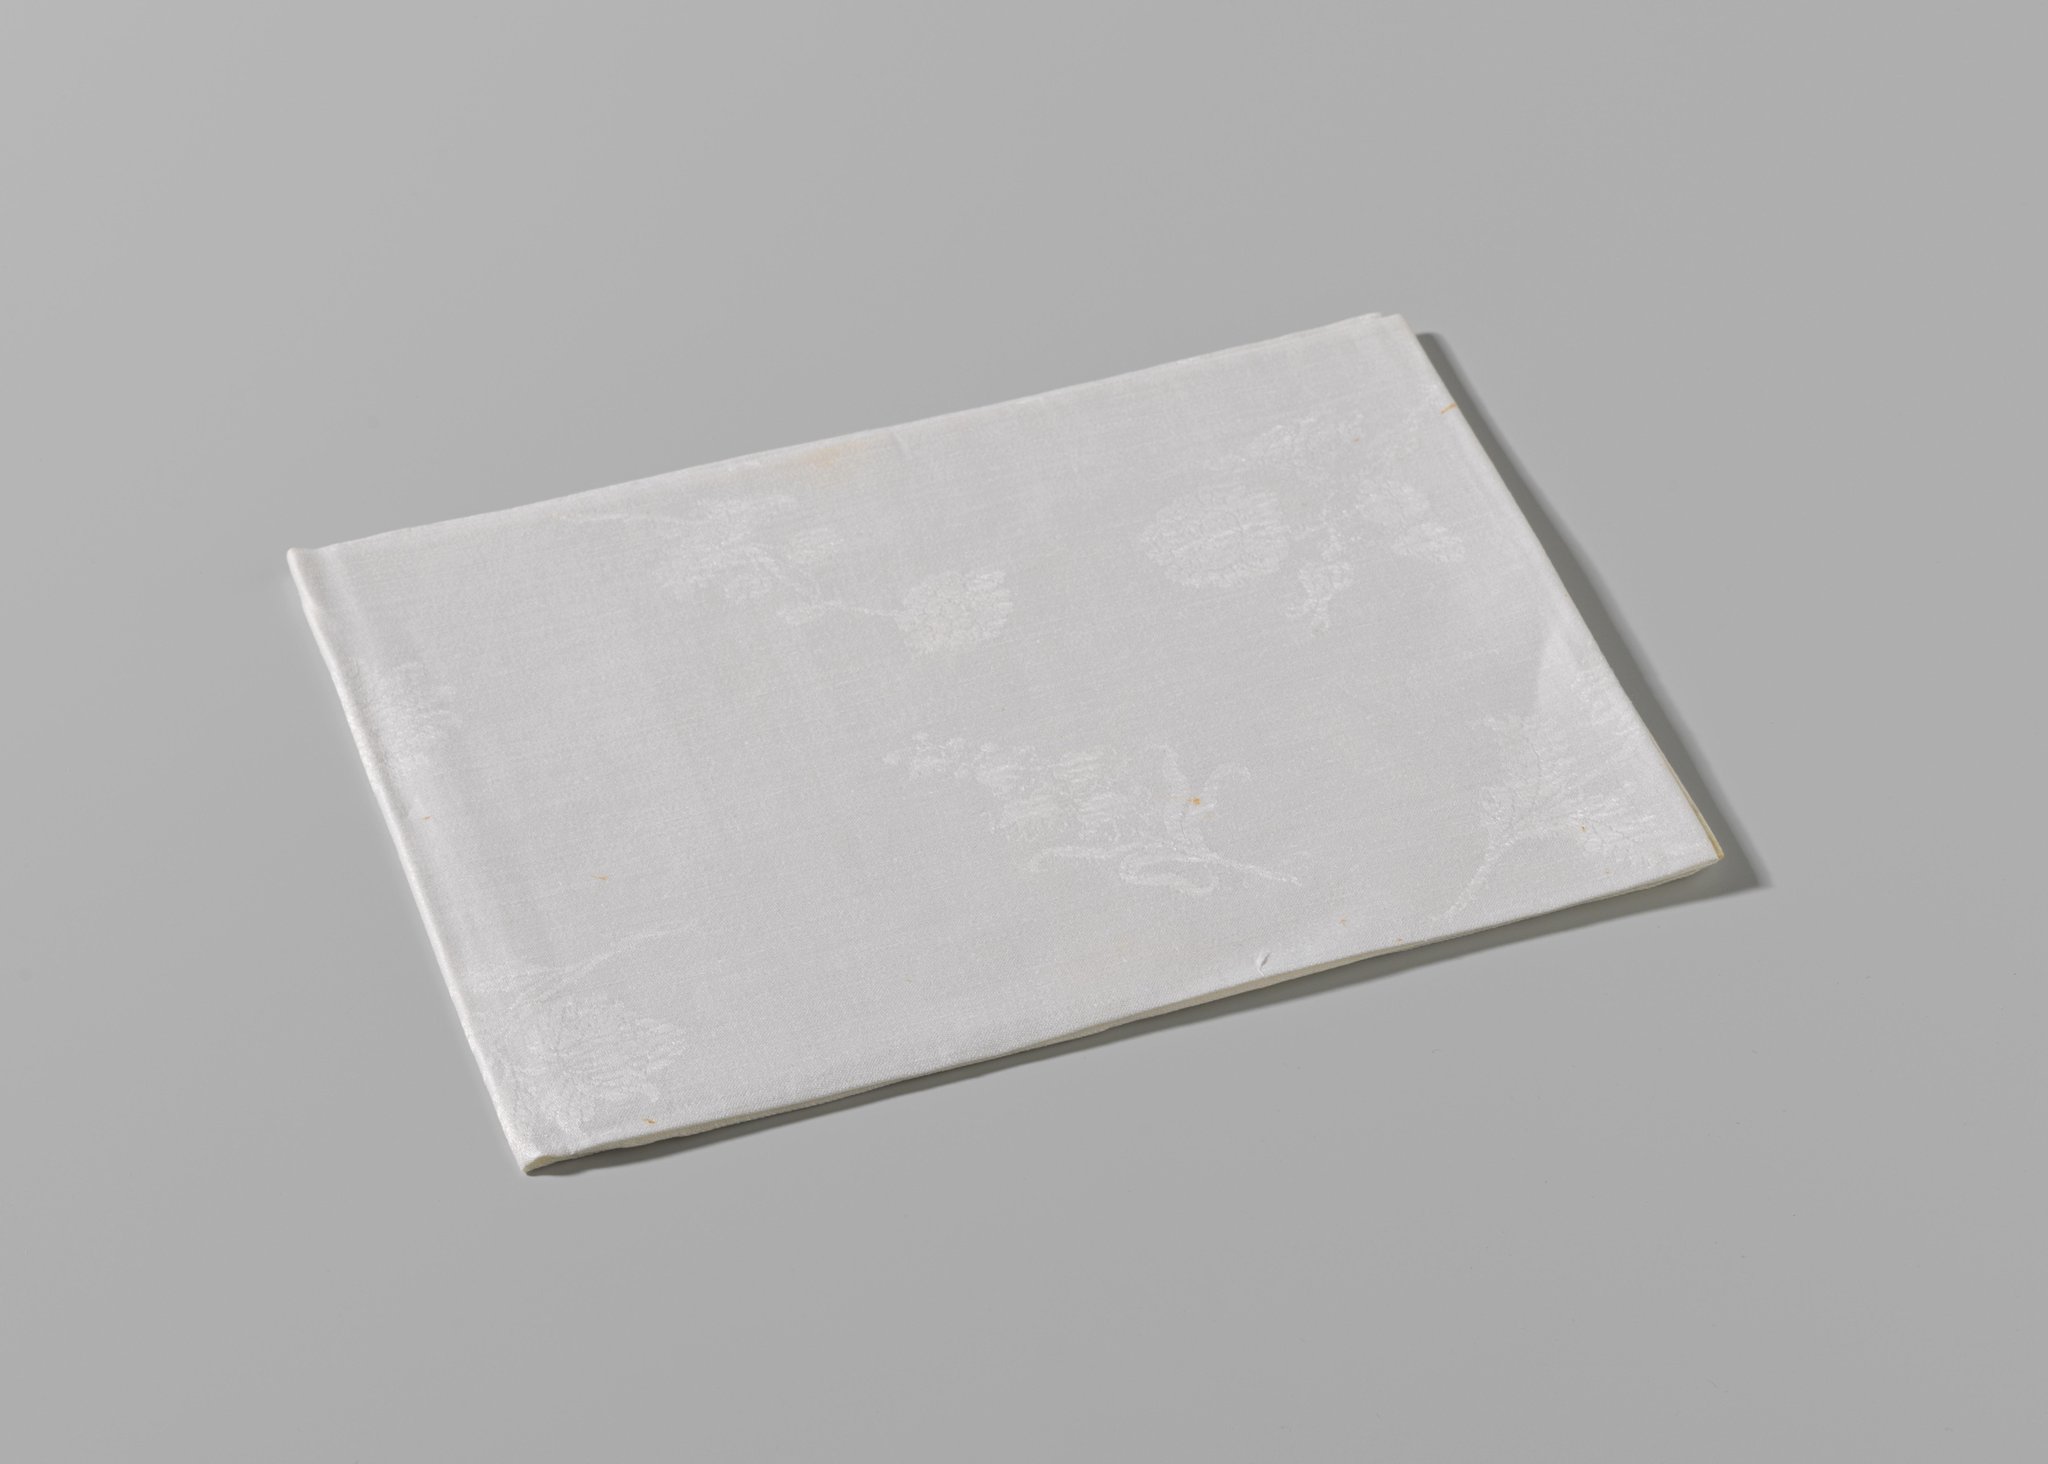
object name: napkin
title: Servet met een bloempatroon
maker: Anonymous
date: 1750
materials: linen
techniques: damask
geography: dresden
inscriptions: mark: ‘21 of 25’, mark: ‘B’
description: Servet van linnendamast met een bloempatroon. Onder andere: roos, ranonkel, lelietje van dalen, anjer, tulp; met stelen die schuin en in rijen tegengesteld gericht zijn. Staande rand: dunne lopende voluutranken, waaraan onder andere kelkbloemen, papaver, chrysant, akelei, en wordt begrensd door grote asymmetrische rocaillemotieven, die op de hoeken naar het midden zijn gericht. Rondom: blokkenrand.